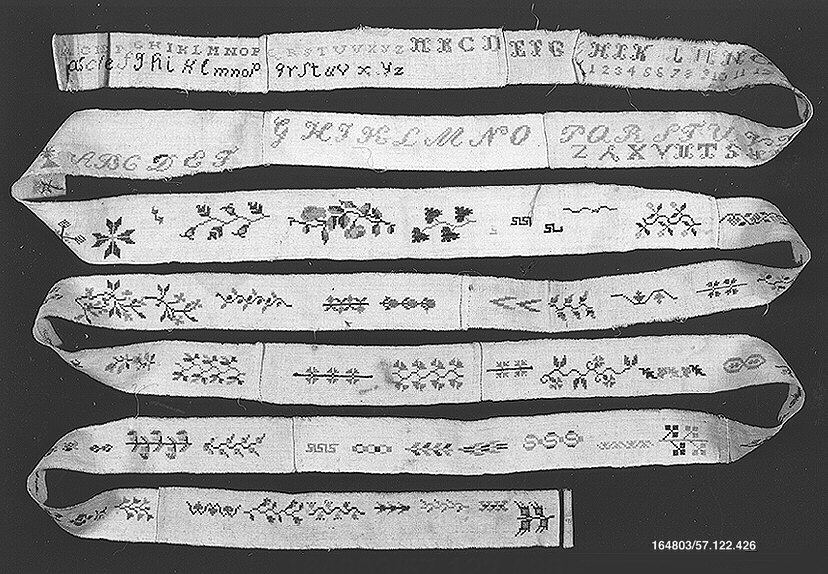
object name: sampler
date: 1801-1900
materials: linen, silk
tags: flowers